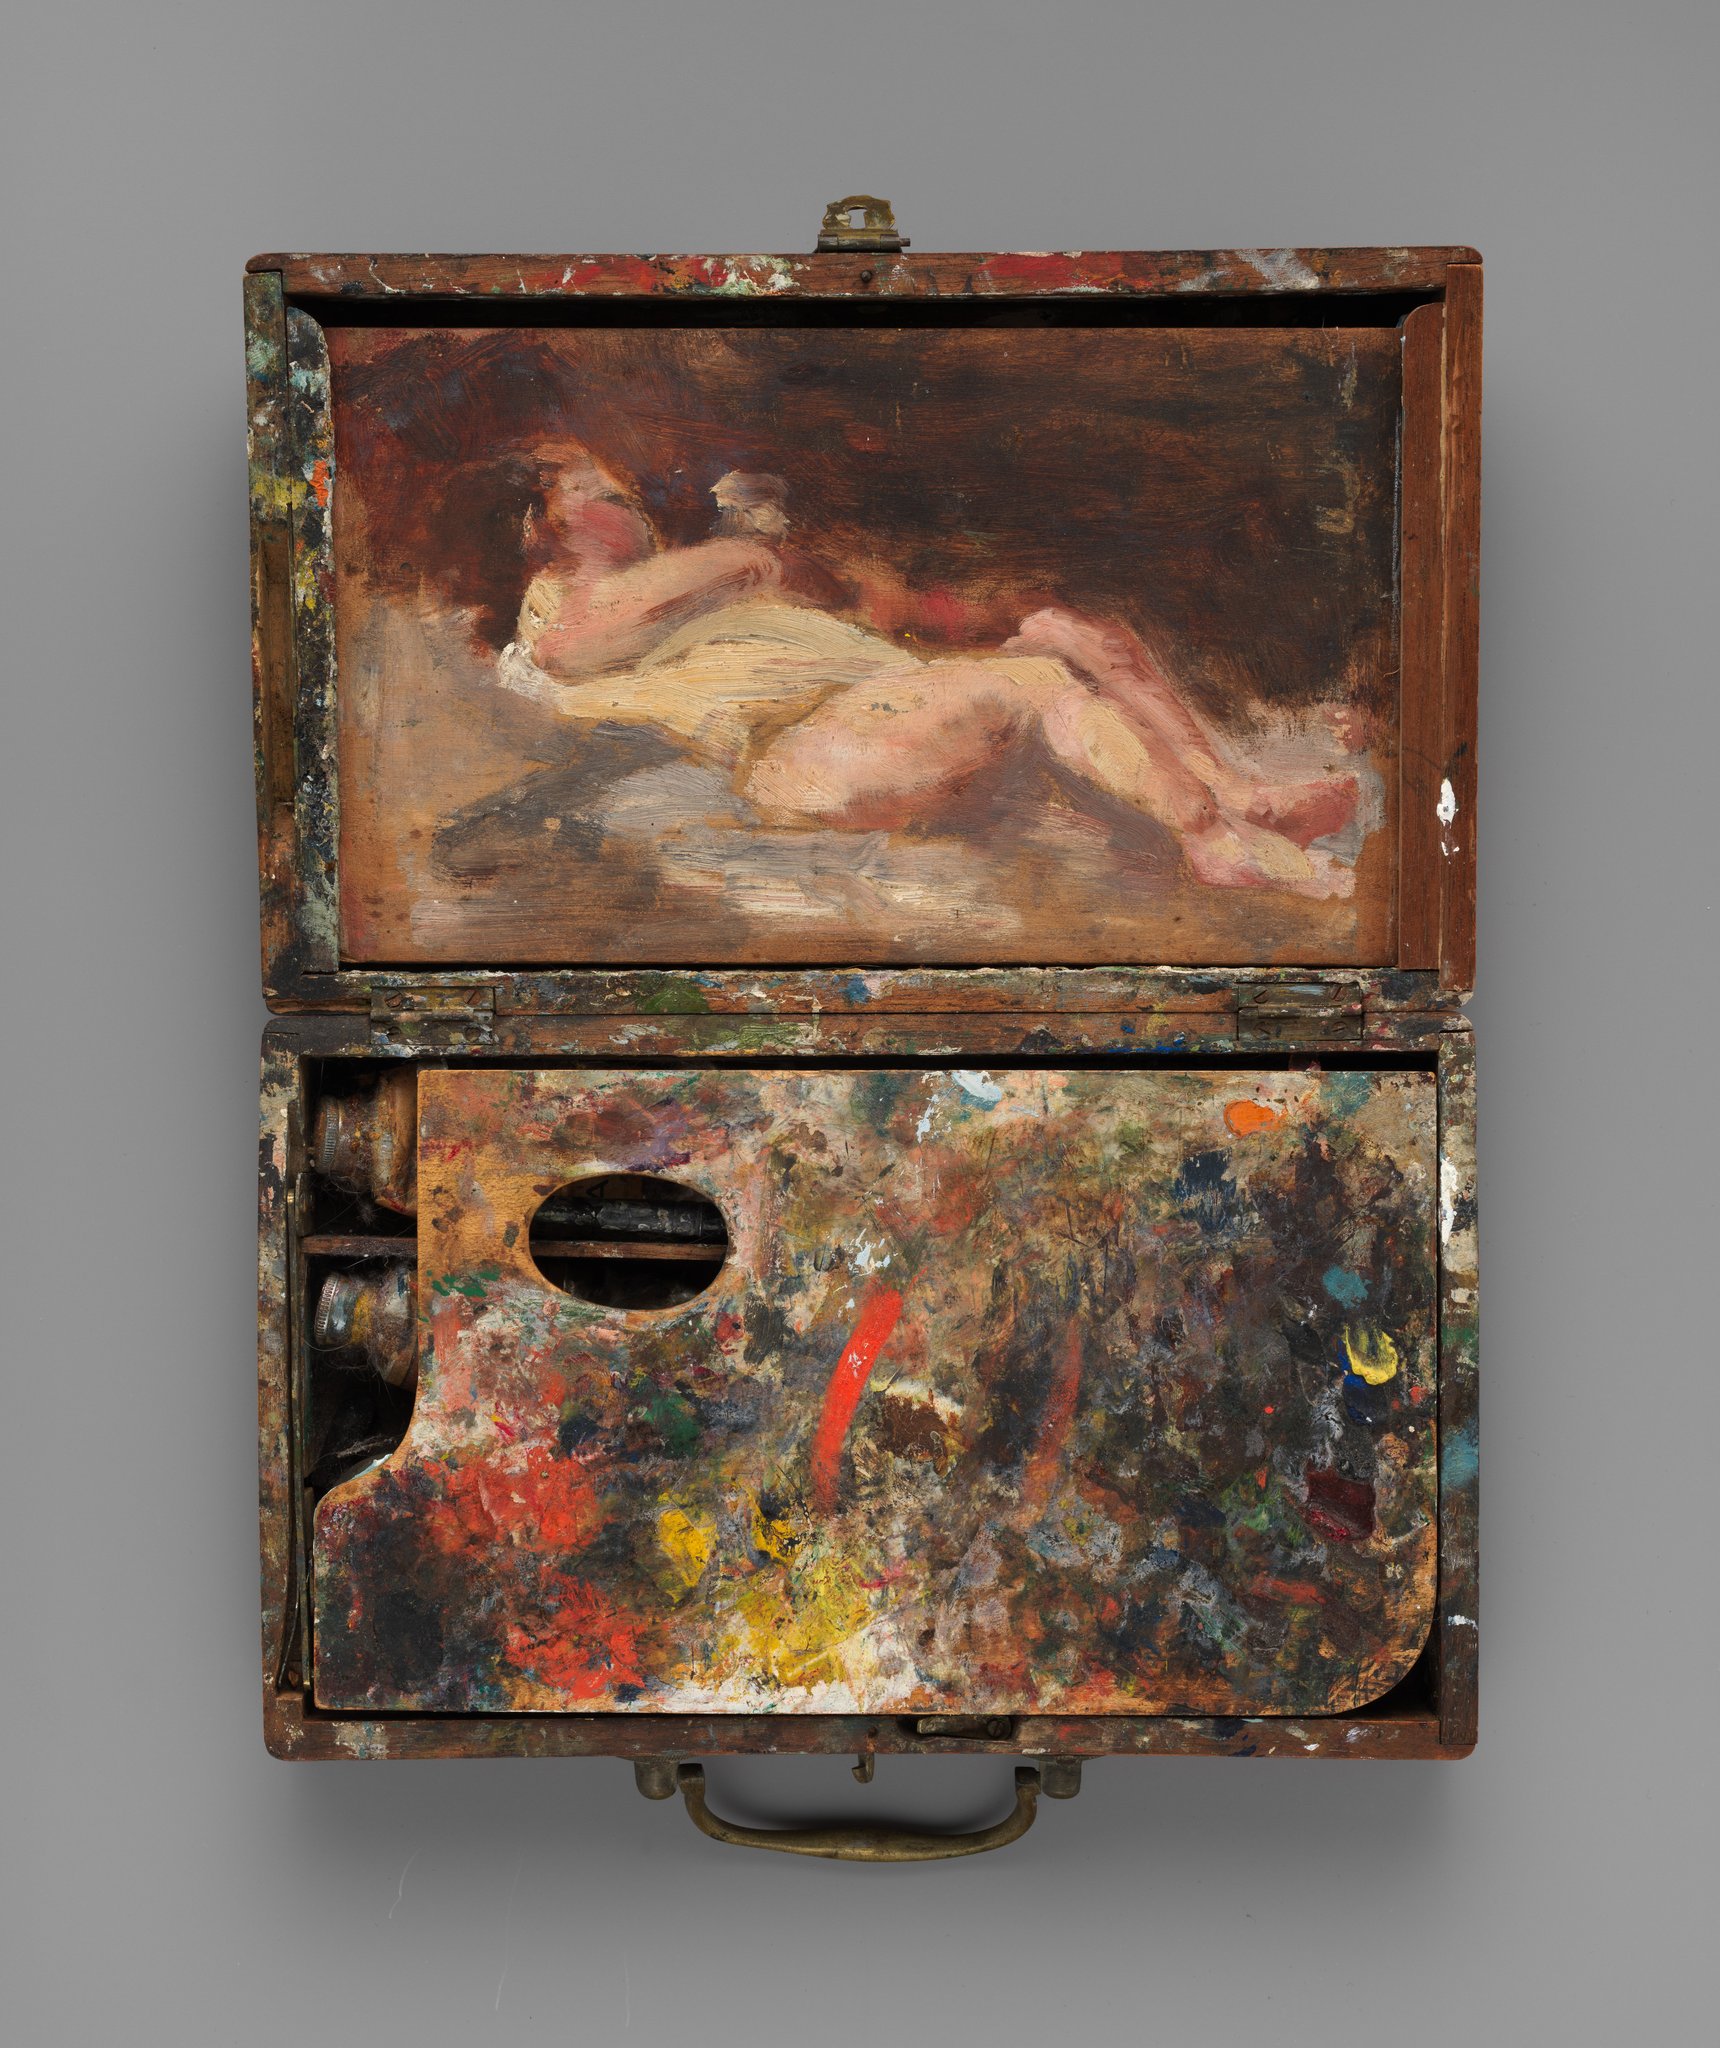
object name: paint box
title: Paint box with nude study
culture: american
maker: helena de kay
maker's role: artist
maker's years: 1846-1916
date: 1871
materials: oil, wood